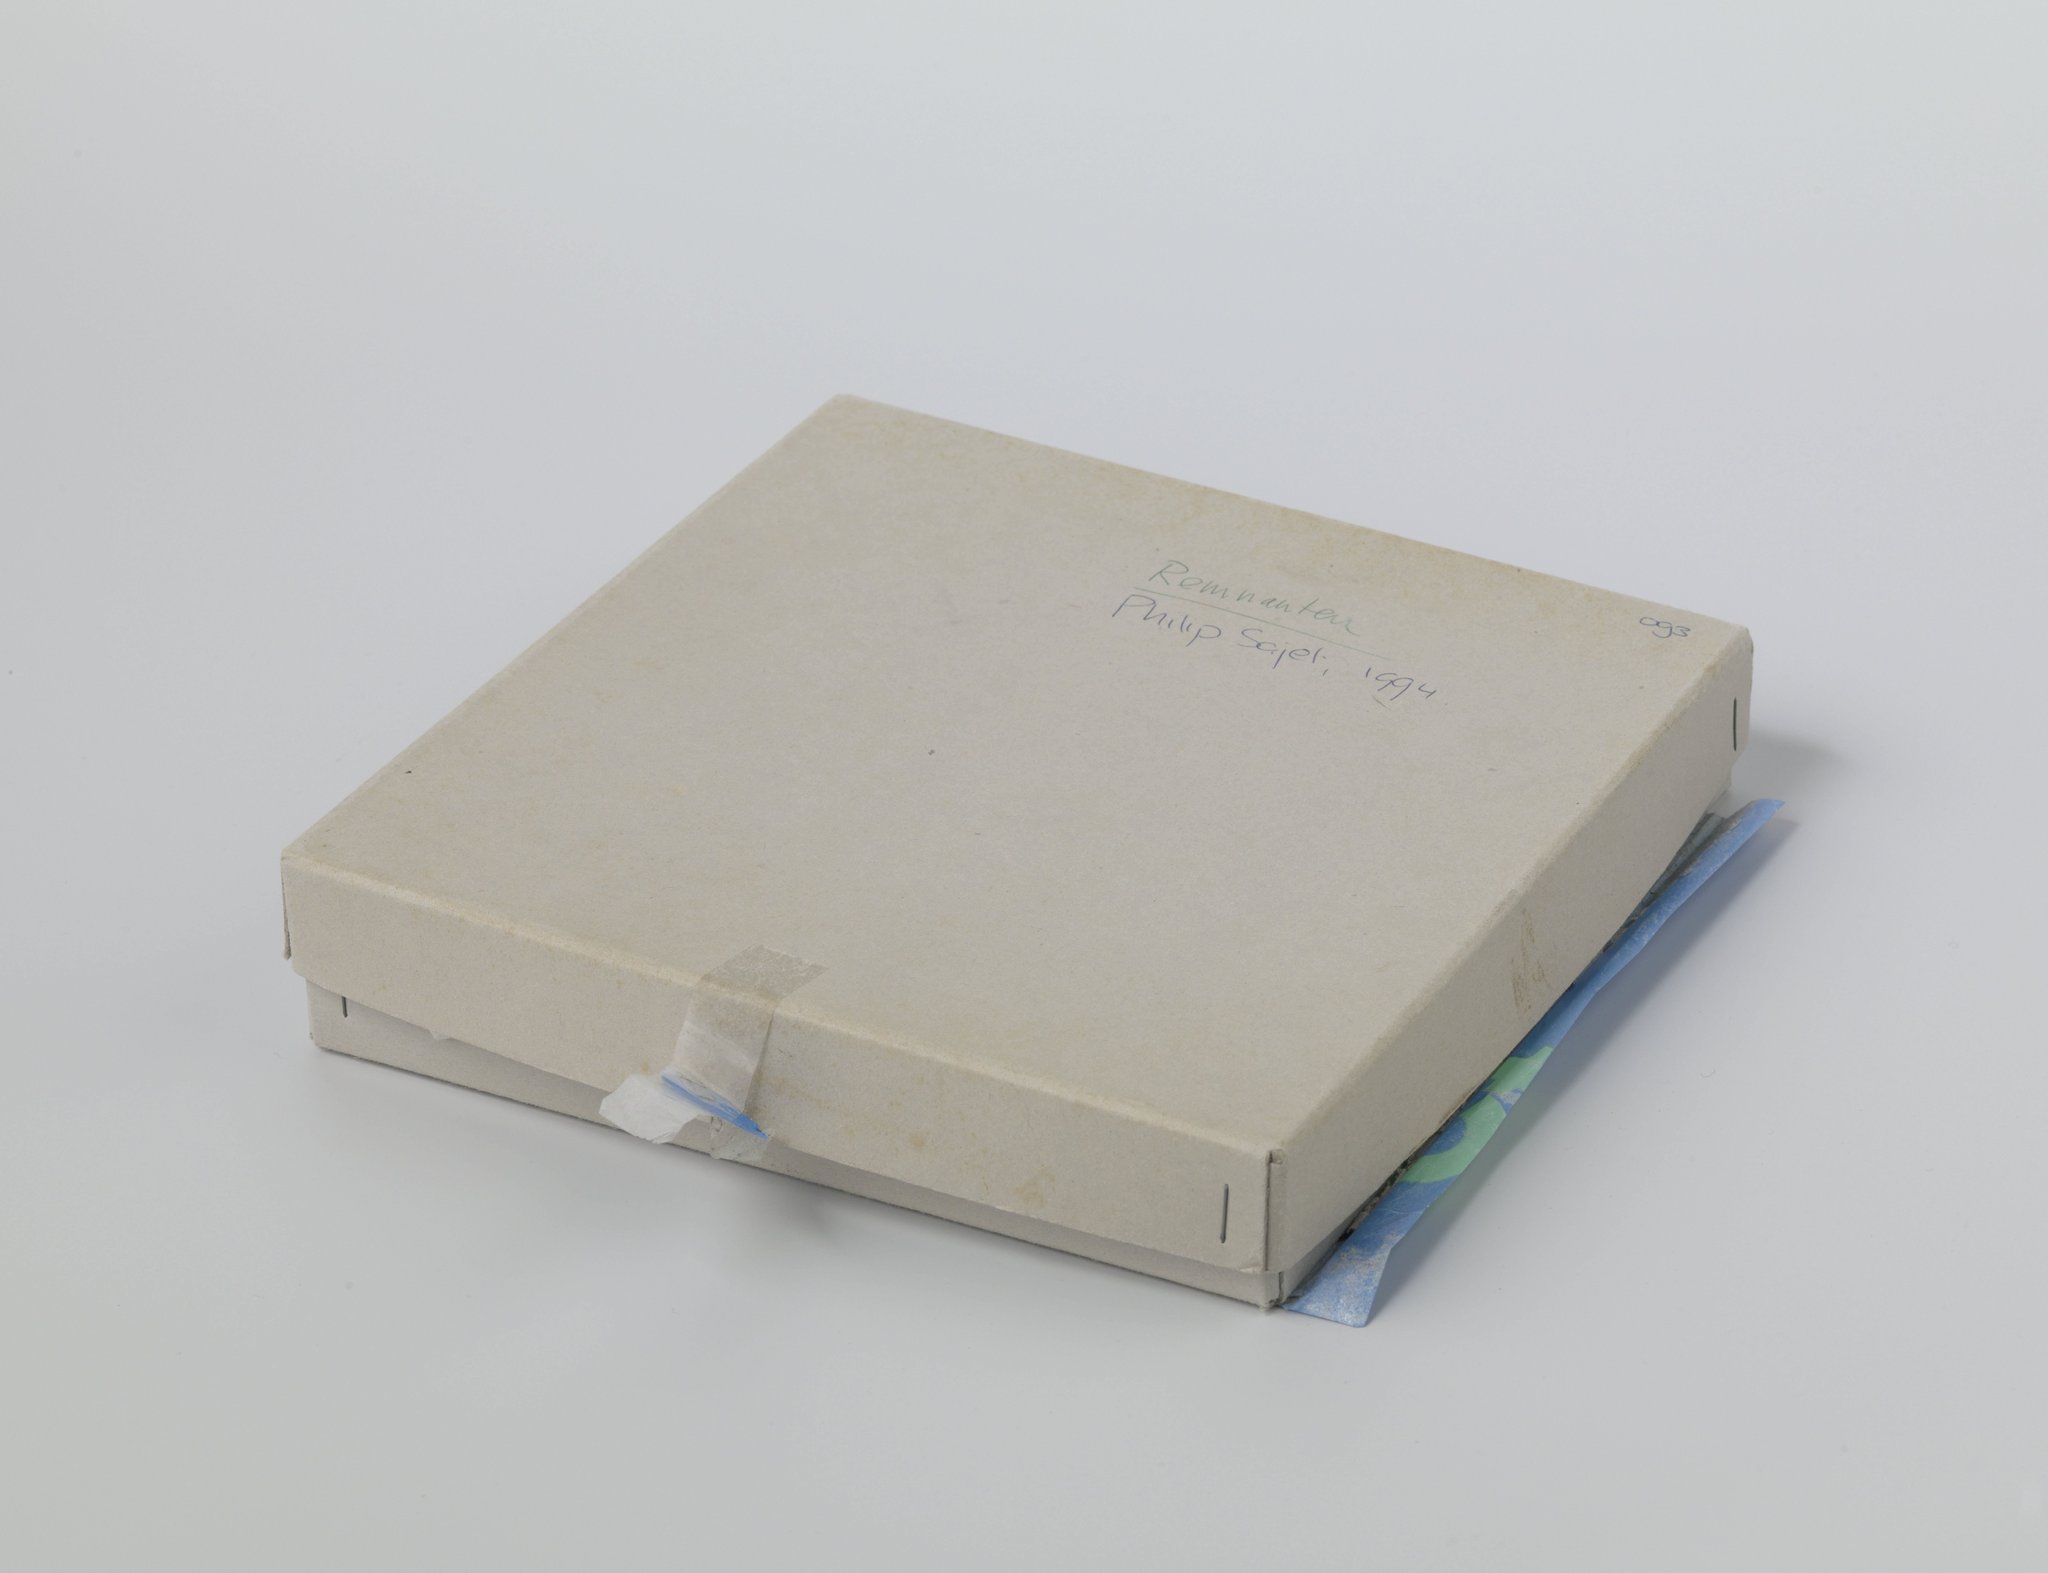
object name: case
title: Geniete kartonnen doos met los deksel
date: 1994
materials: cardboard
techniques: stapling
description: Doos horend bij kraagcollier 'Remnanten' (BK-2010-2-125-1).